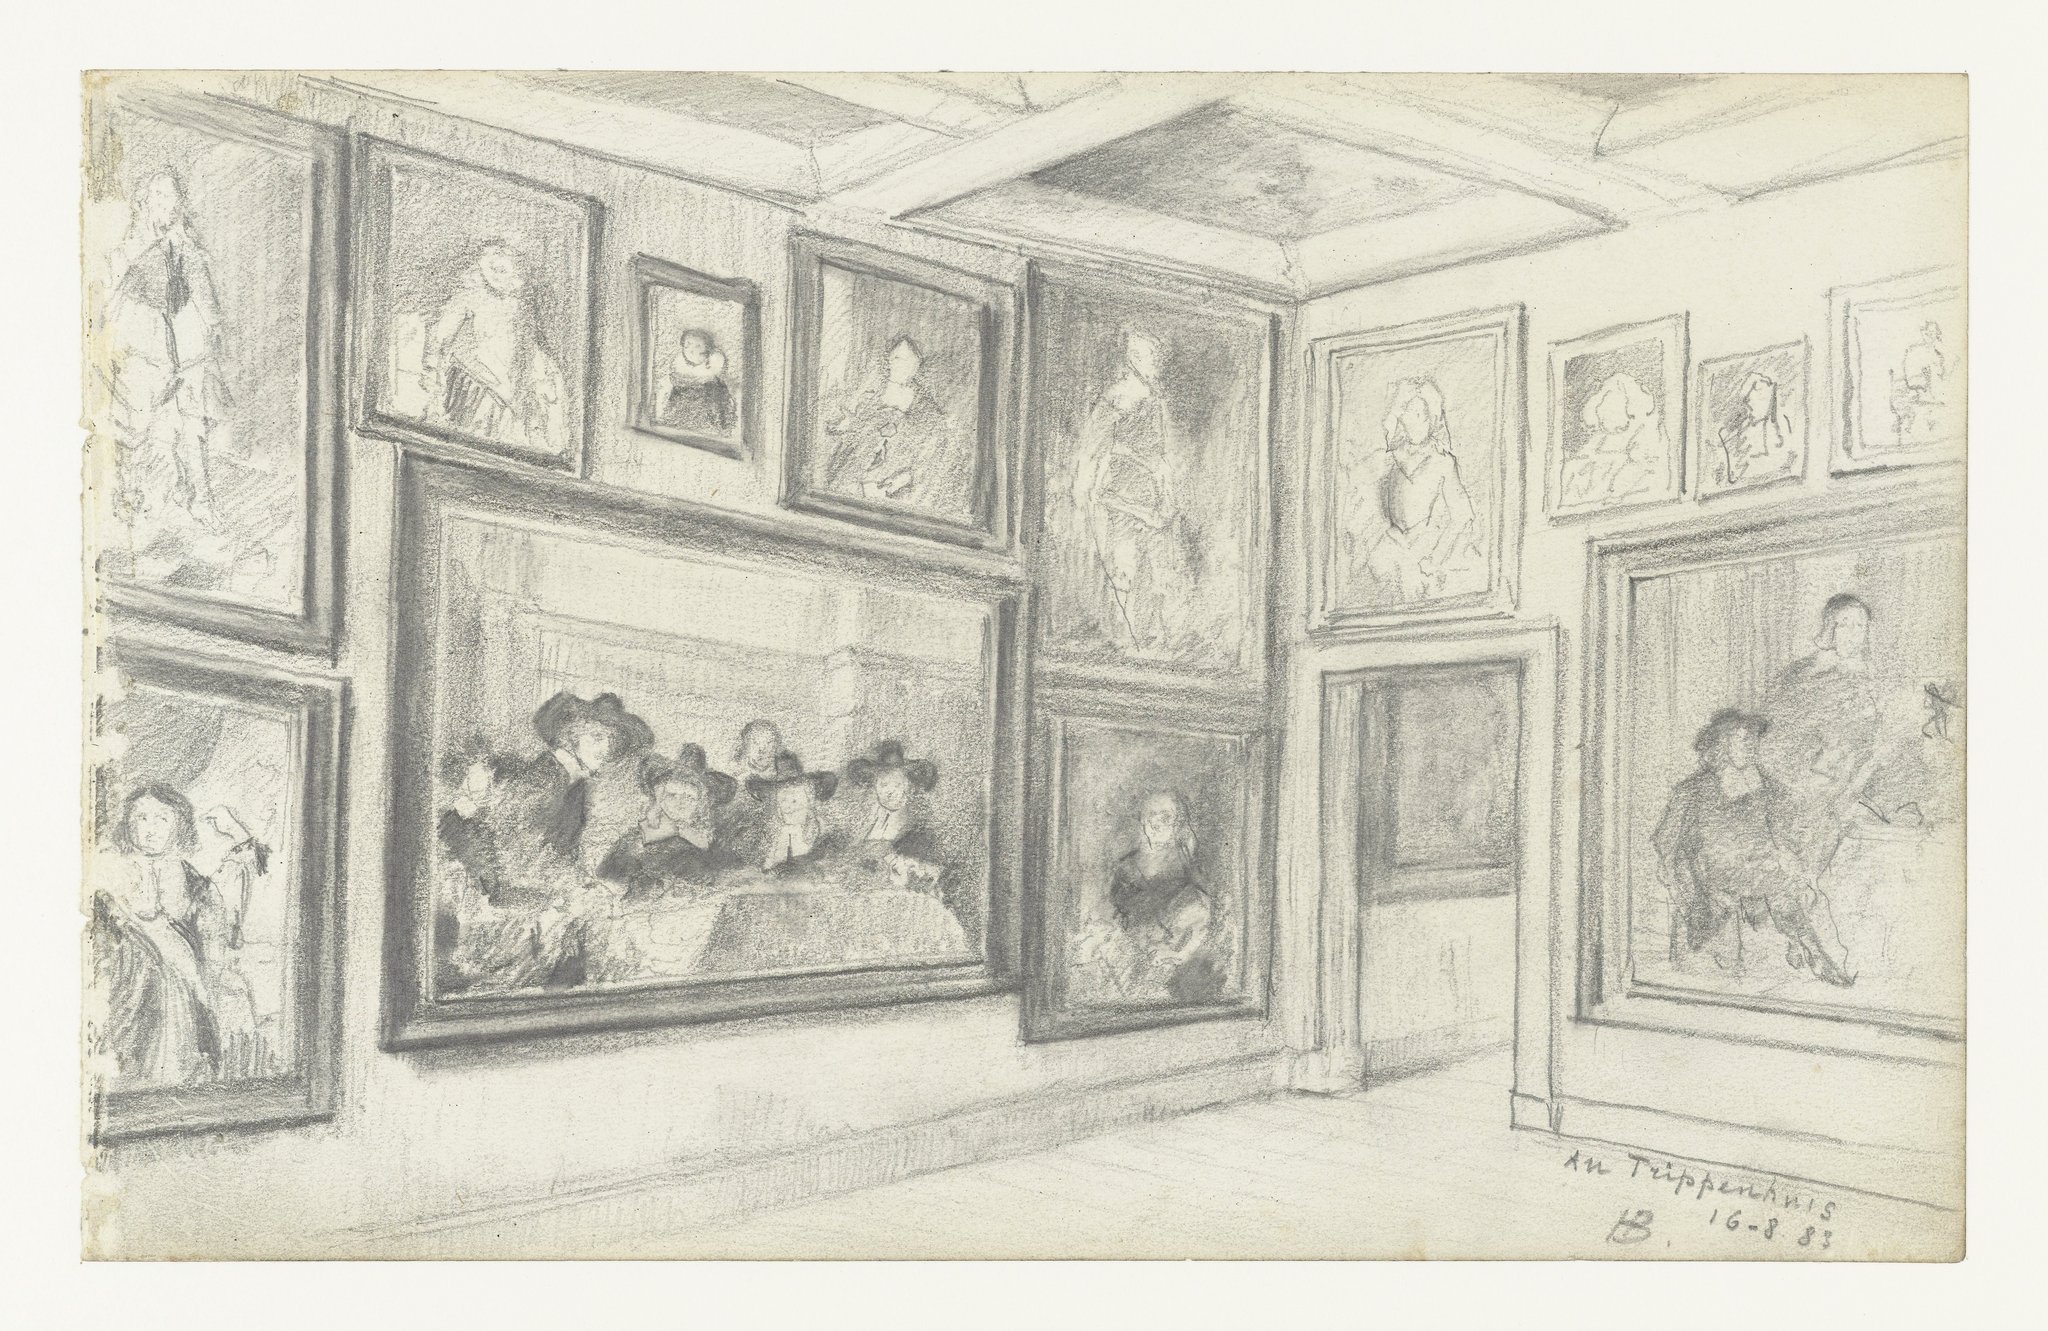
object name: drawing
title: Zaal in het Trippenhuis met schilderijen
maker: henri de braekeleer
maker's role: draughtsman, print maker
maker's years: 1840-1888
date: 1883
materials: paper, pencil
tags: permanent exhibition, museum, 'gemalte galerie', amsterdam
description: Zaal in het Trippenhuis met onder andere De Staalmeesters van Rembrandt.